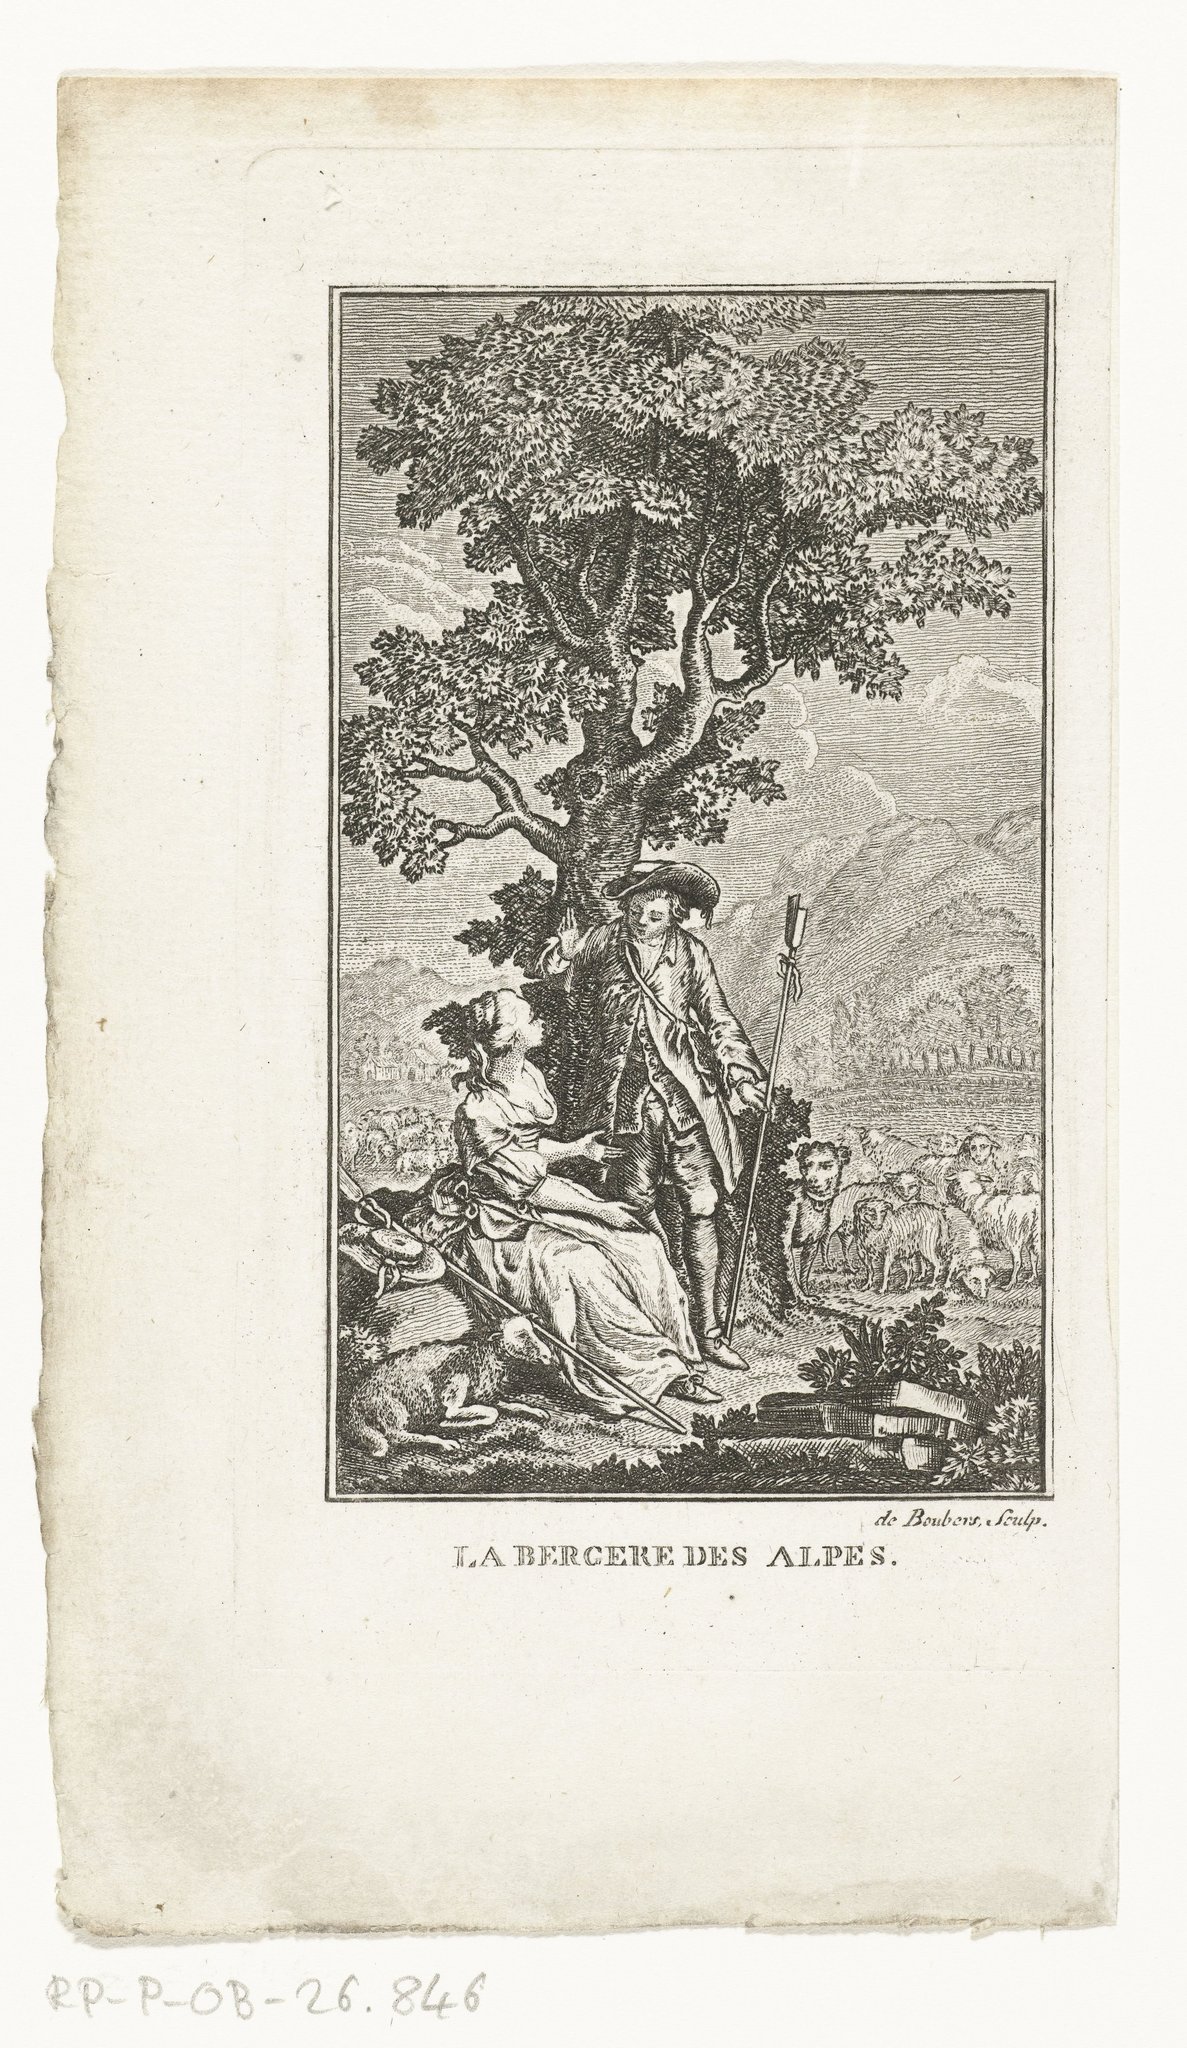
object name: book illustration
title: La Bergere des Alpes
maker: n. de boubers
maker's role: print maker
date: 1765-1780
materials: paper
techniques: engraving, etching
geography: paris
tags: pastorals, arcadian scenes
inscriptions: collector's mark: Lugt 2228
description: Illustratie voor het verhaal 'La Bergere des Alpes' uit J.F. Marmontel's verhalenbundel 'Contes moreaux'. Een herderin zit uit te rusten in de schaduw van een boom. Een jonge herder maakt een praatje met haar. De schapen grazen in een bergachtig landschap.